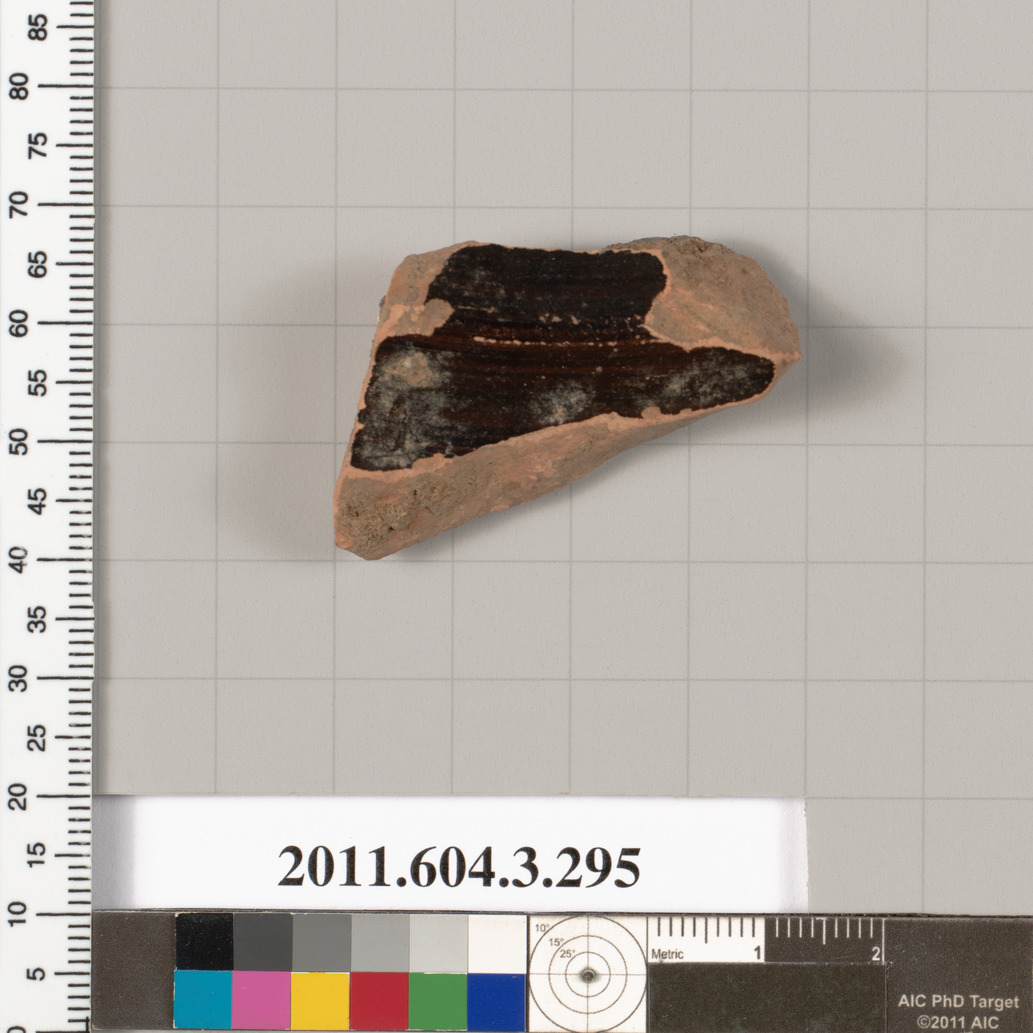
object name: neck amphora fragment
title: Terracotta fragment of a neck-amphora (jar)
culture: greek, attic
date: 600-401 BCE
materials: terracotta